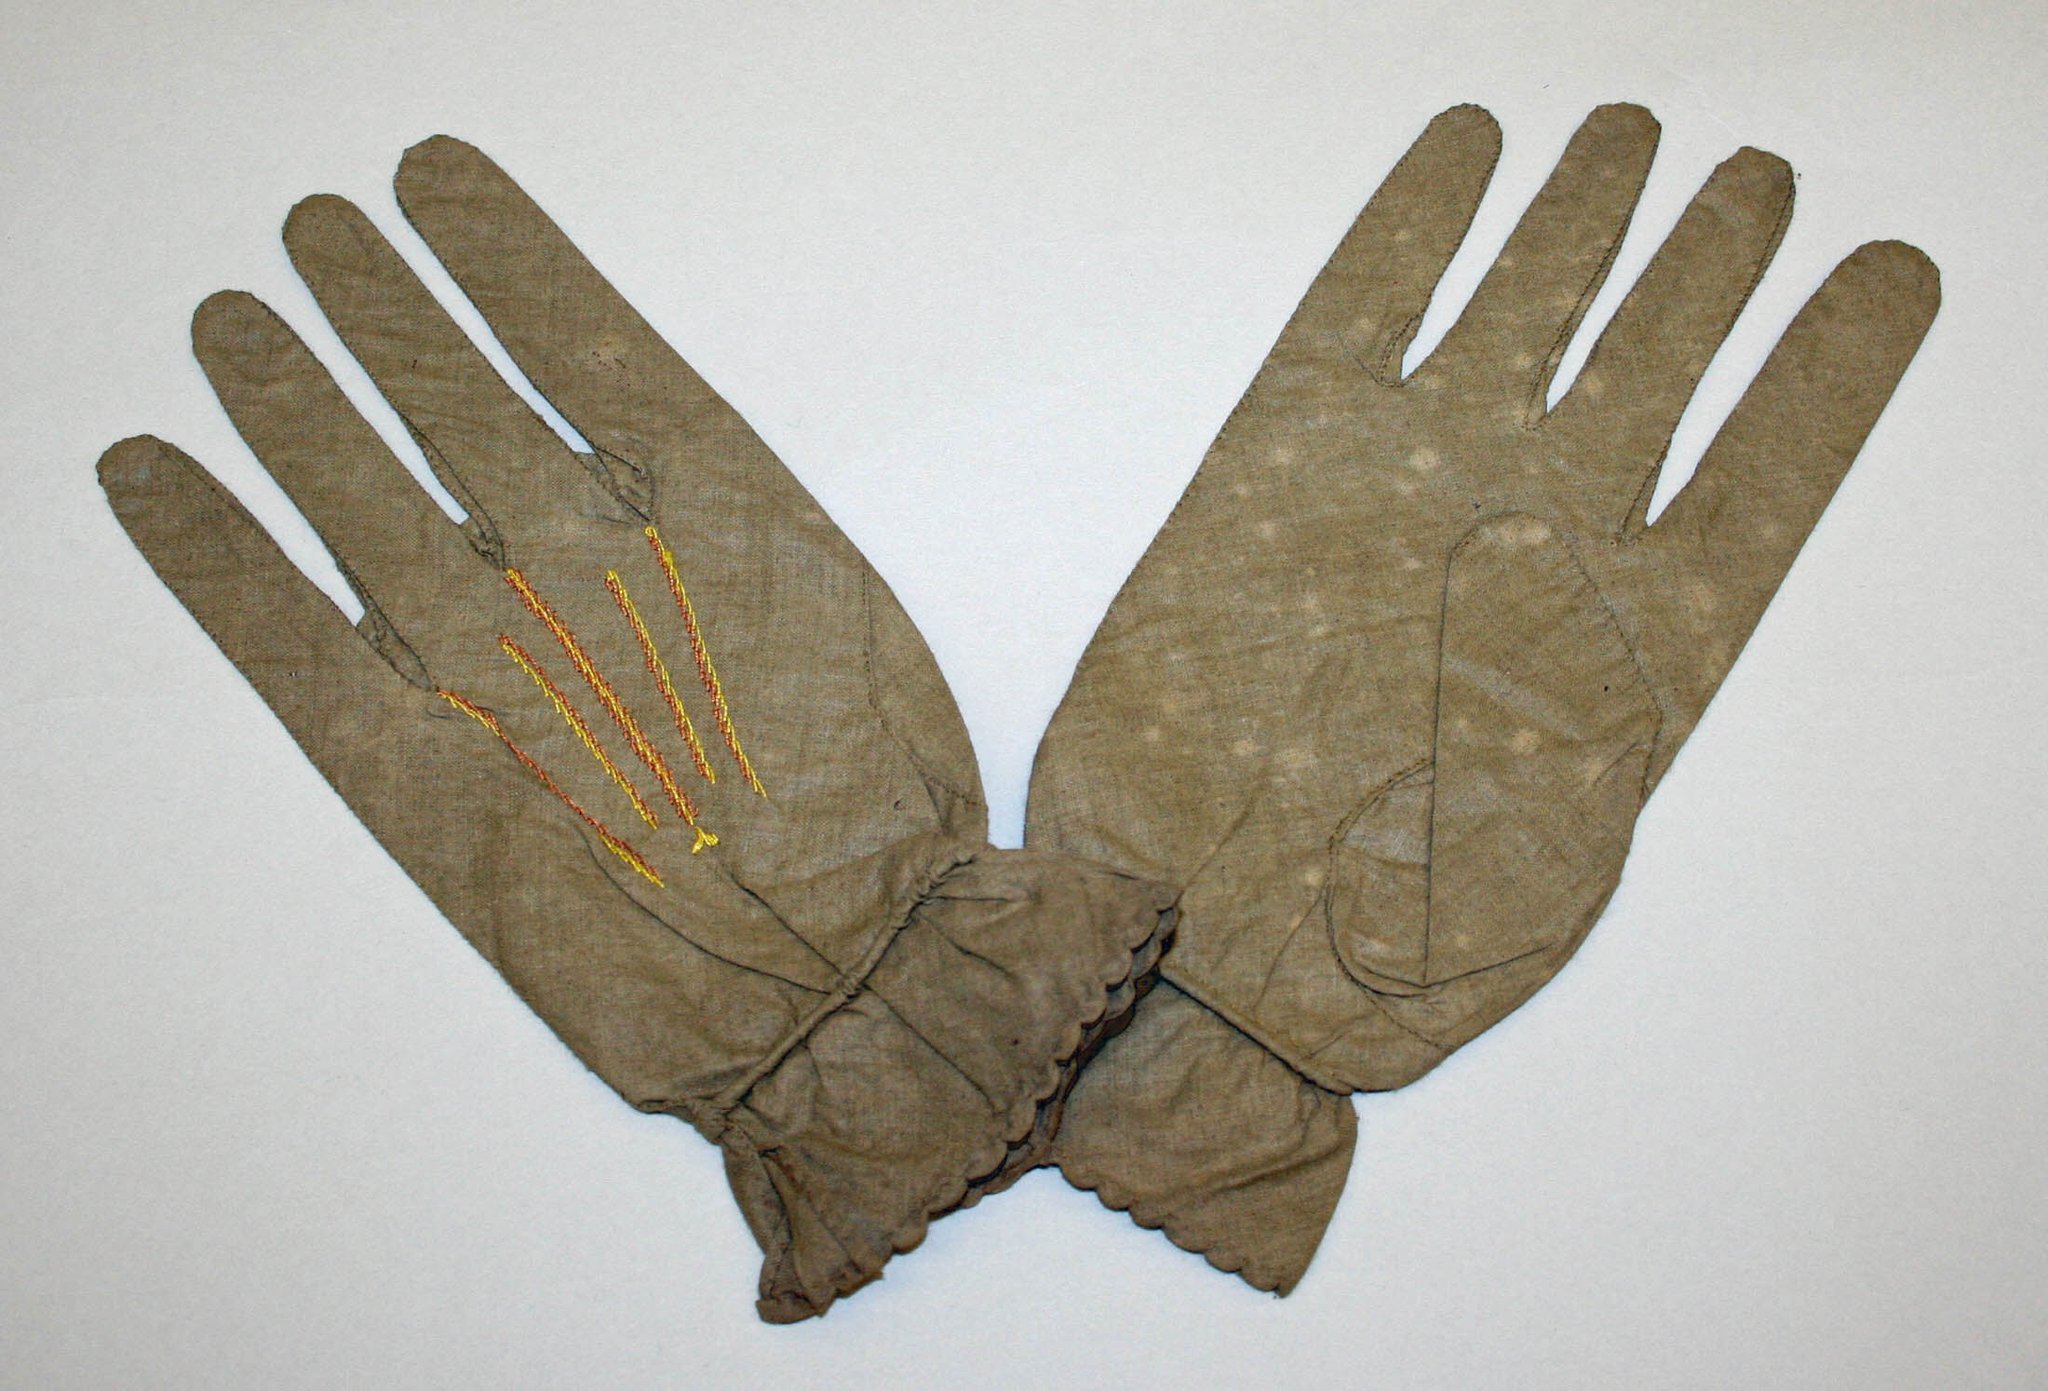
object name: glove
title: Gloves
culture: european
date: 1850-1859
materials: cotton